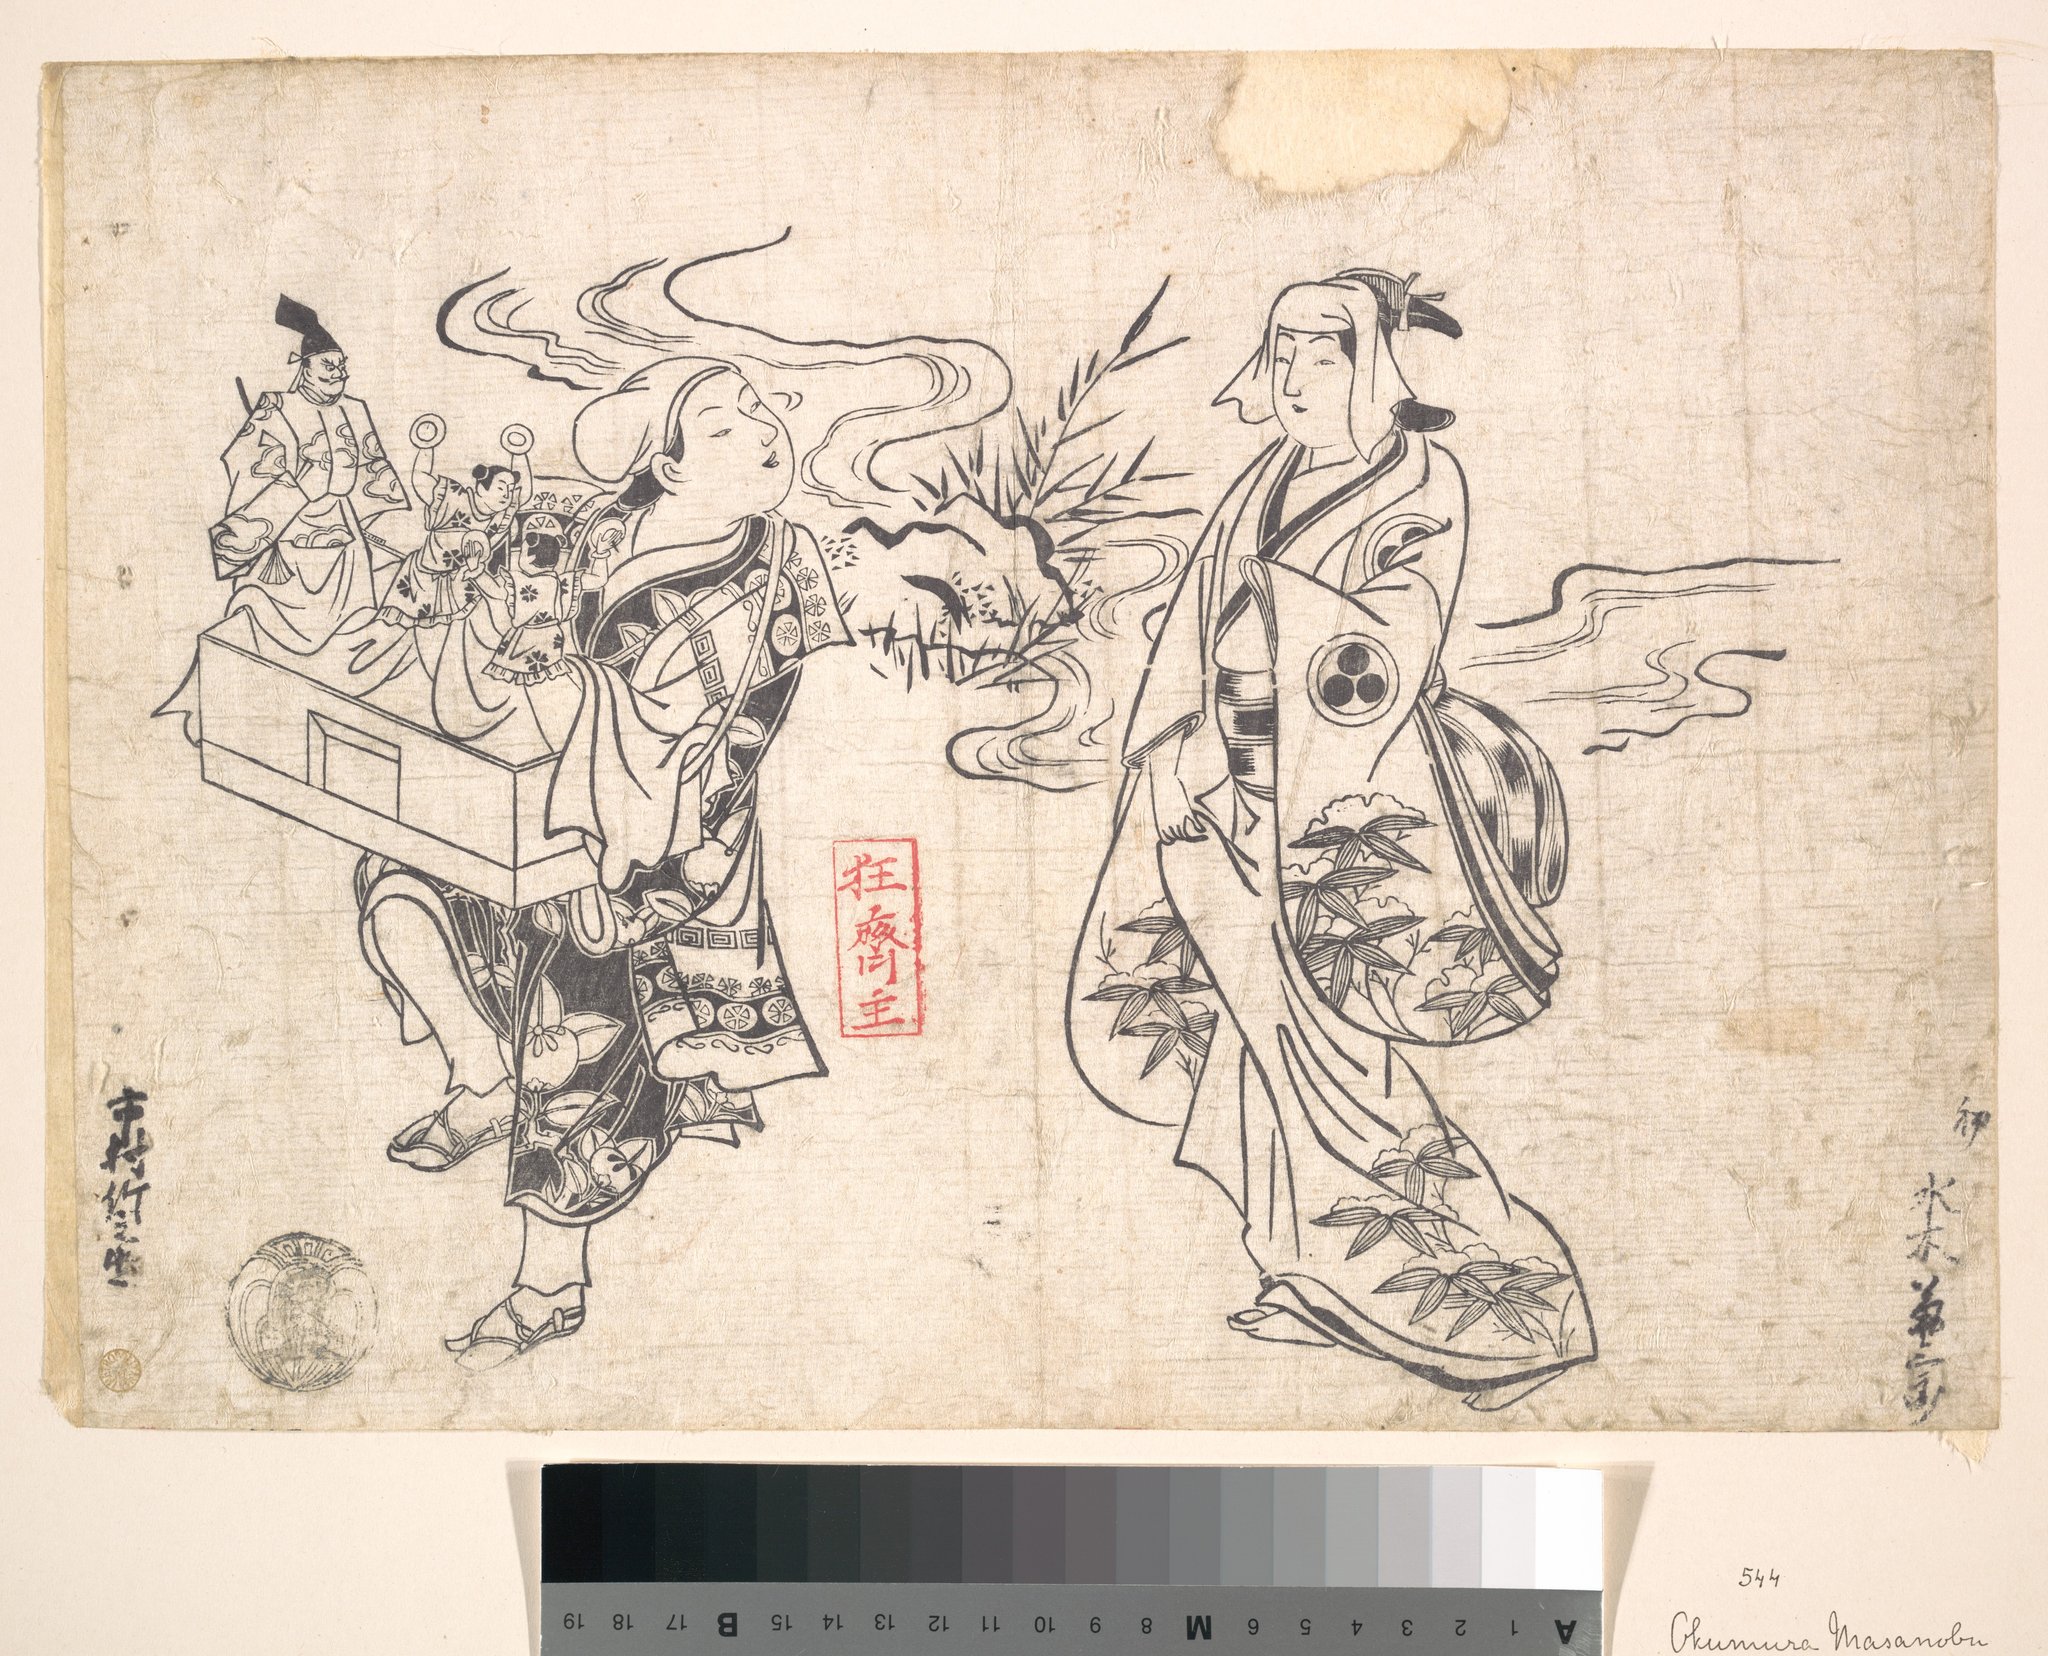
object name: print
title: Mizuki Kikusaburo as a Woman Standing near a Small Stream and Looking at a Wandering Puppet-showman Impersonated by Ichimura Takenojo (Later Known as the 8th Ichimura Uzaemon)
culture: japanese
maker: okumura masanobu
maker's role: artist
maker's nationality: japanese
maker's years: 1686-1764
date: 1709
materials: ink, paper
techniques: woodblock print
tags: women,actors,puppets